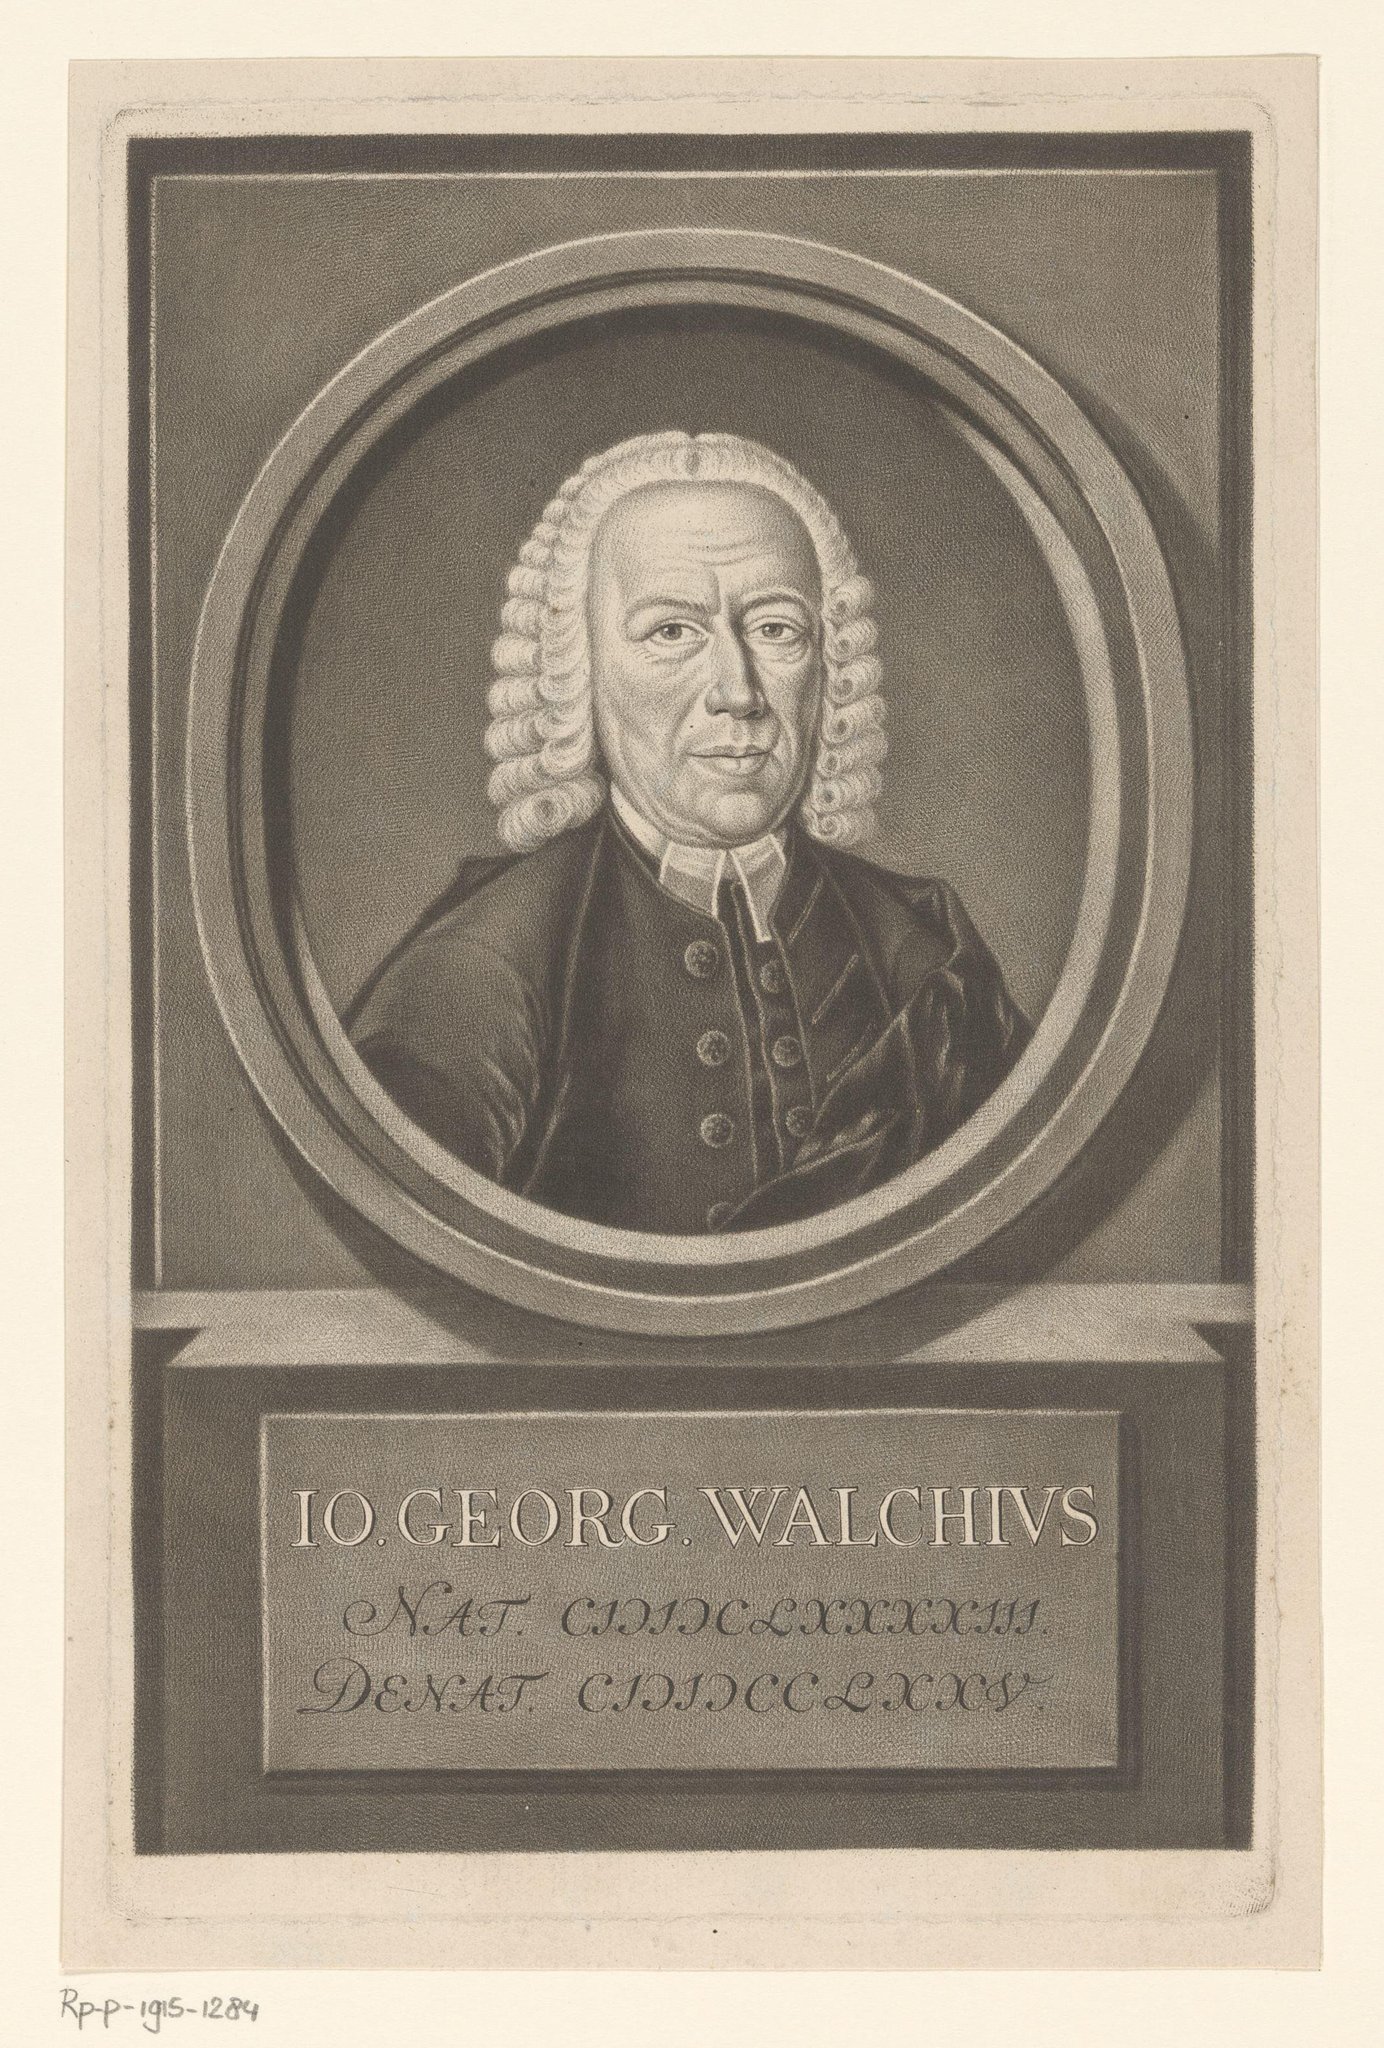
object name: print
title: Portret van Johann Georg Walch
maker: johann elias haid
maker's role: print maker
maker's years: 1739-1809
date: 1775-1809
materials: paper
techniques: mezzotint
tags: theologian, historical persons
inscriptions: collector's mark: Lugt 2228